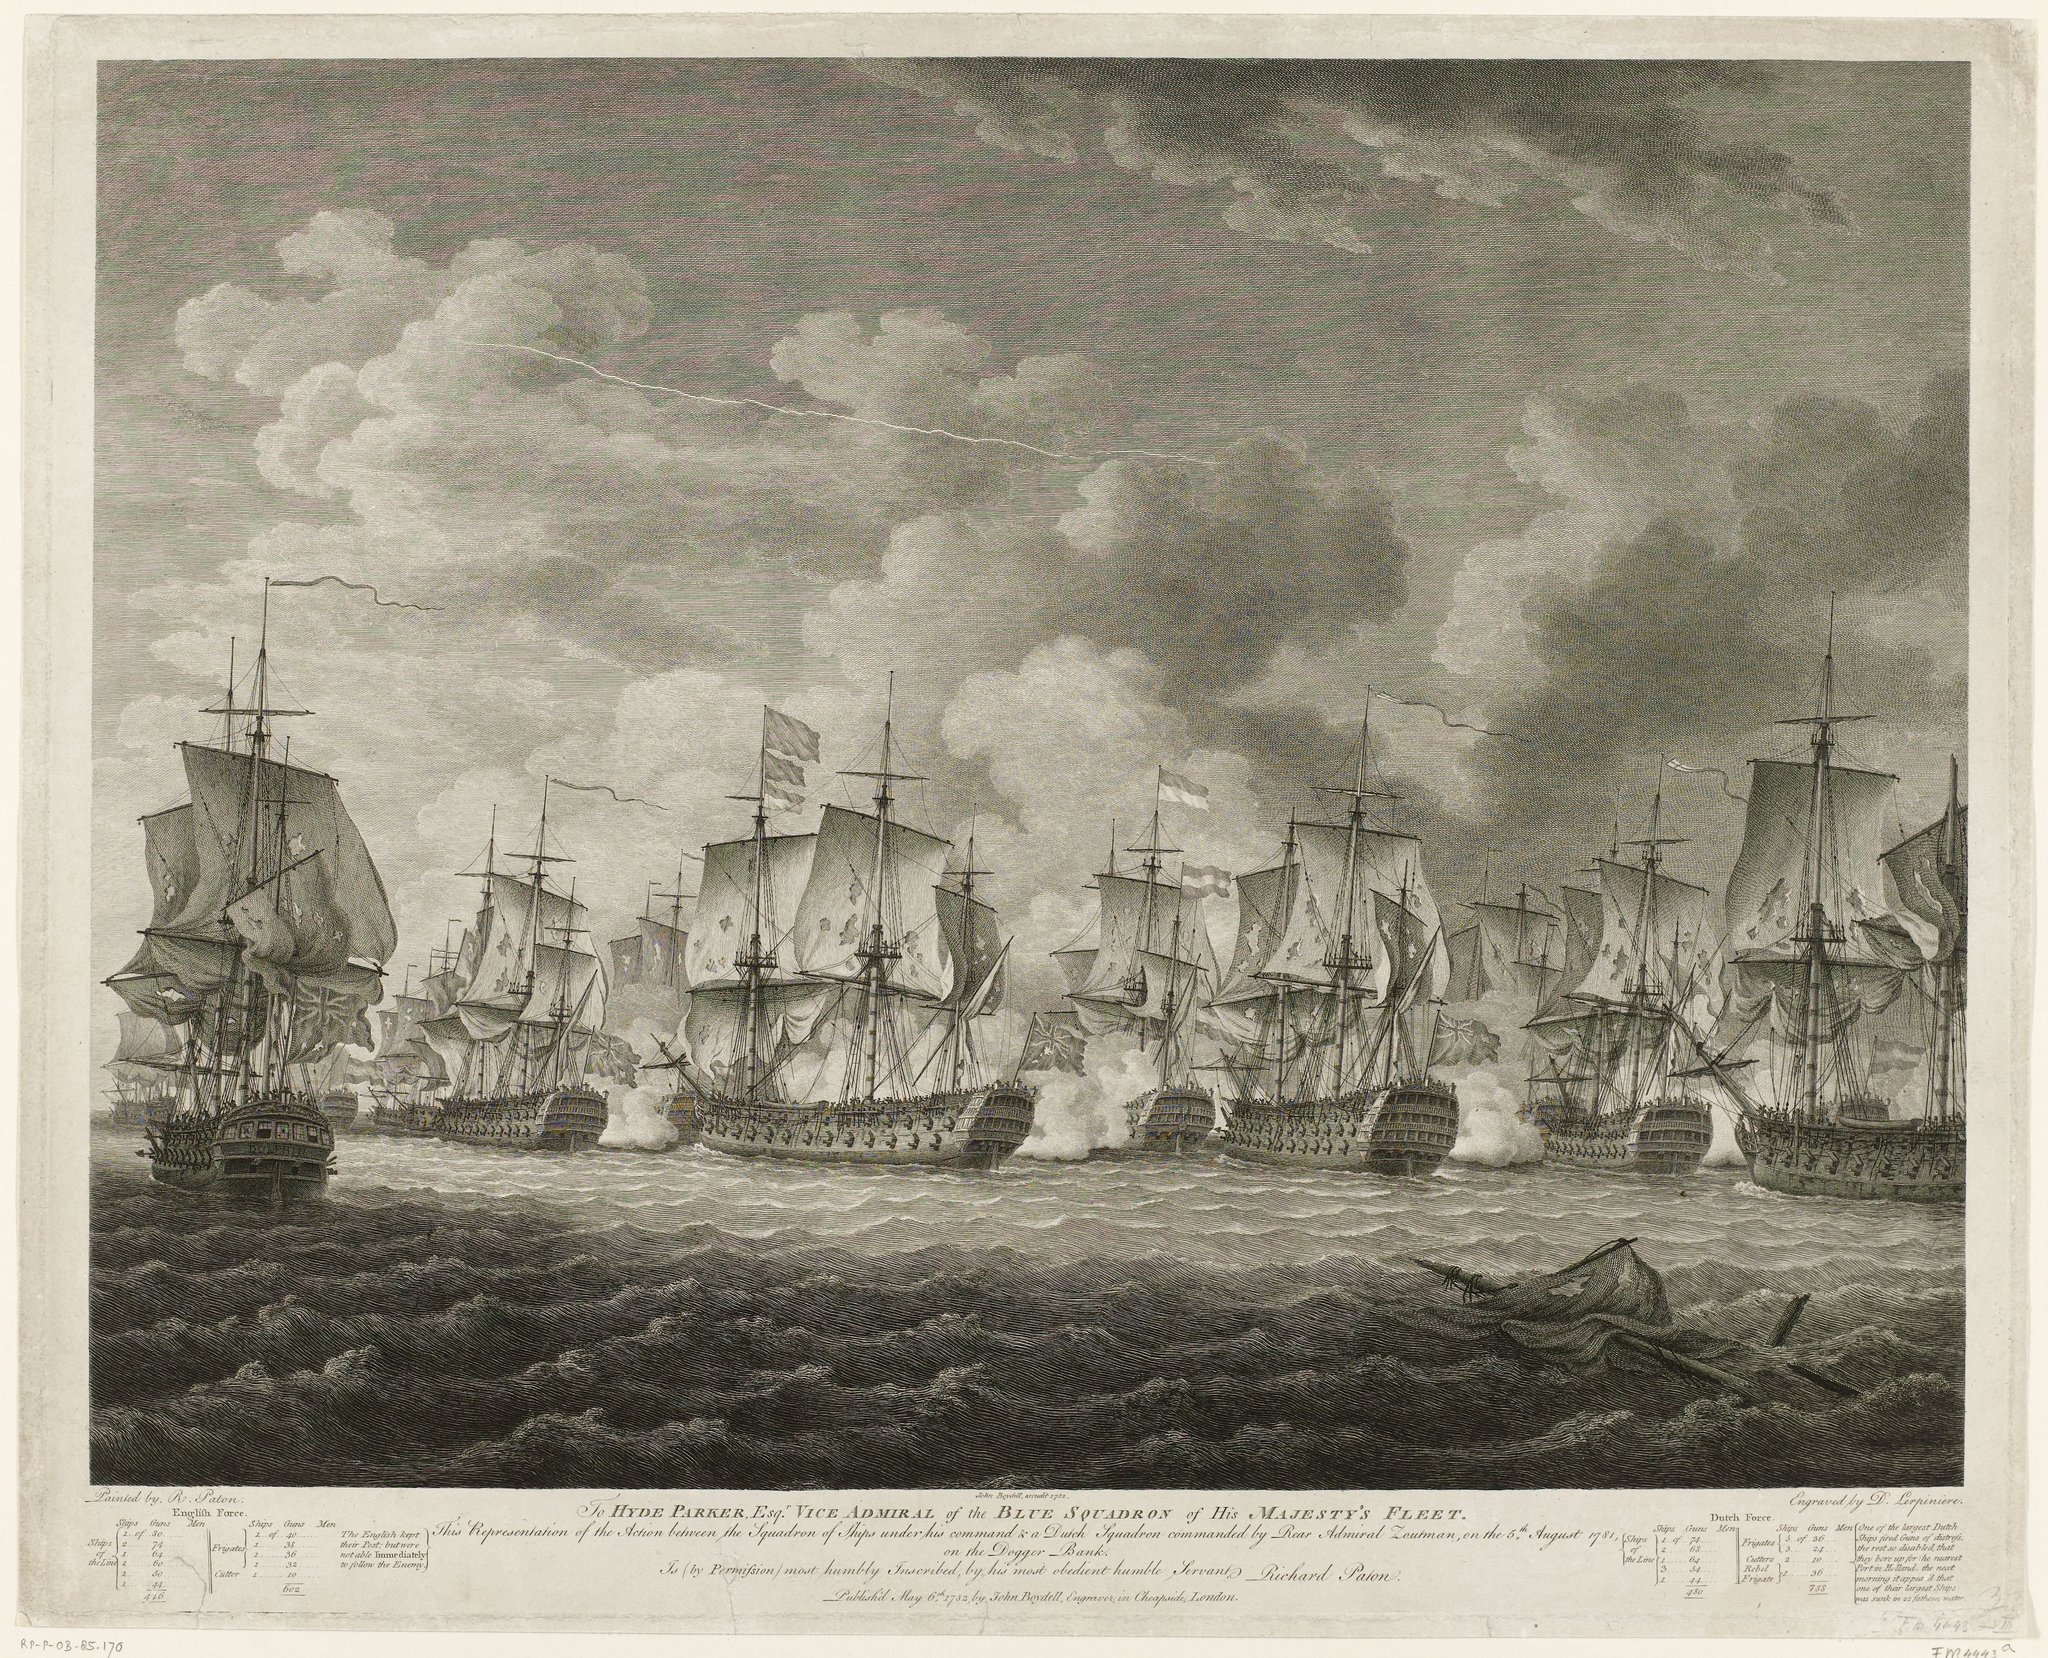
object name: print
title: Zeeslag bij Doggersbank, 1781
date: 1782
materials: paper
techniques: engraving, etching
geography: england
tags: the hague, johan arnold zoutman, hyde parker, battle (+ naval force)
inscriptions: collector's mark: Lugt 2228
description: De Nederlandse en Engelse schepen tijdens de zeeslag bij Doggersbank op 5 augustus 1781 tussen de Nederlandse vloot onder schout-bij-nacht Johan Zoutman en de Engelse vloot onder vice-admiraal Hyde Parker. In het onderschrift de opdracht aan Parker en een overzicht van de fregatten van beide landen.